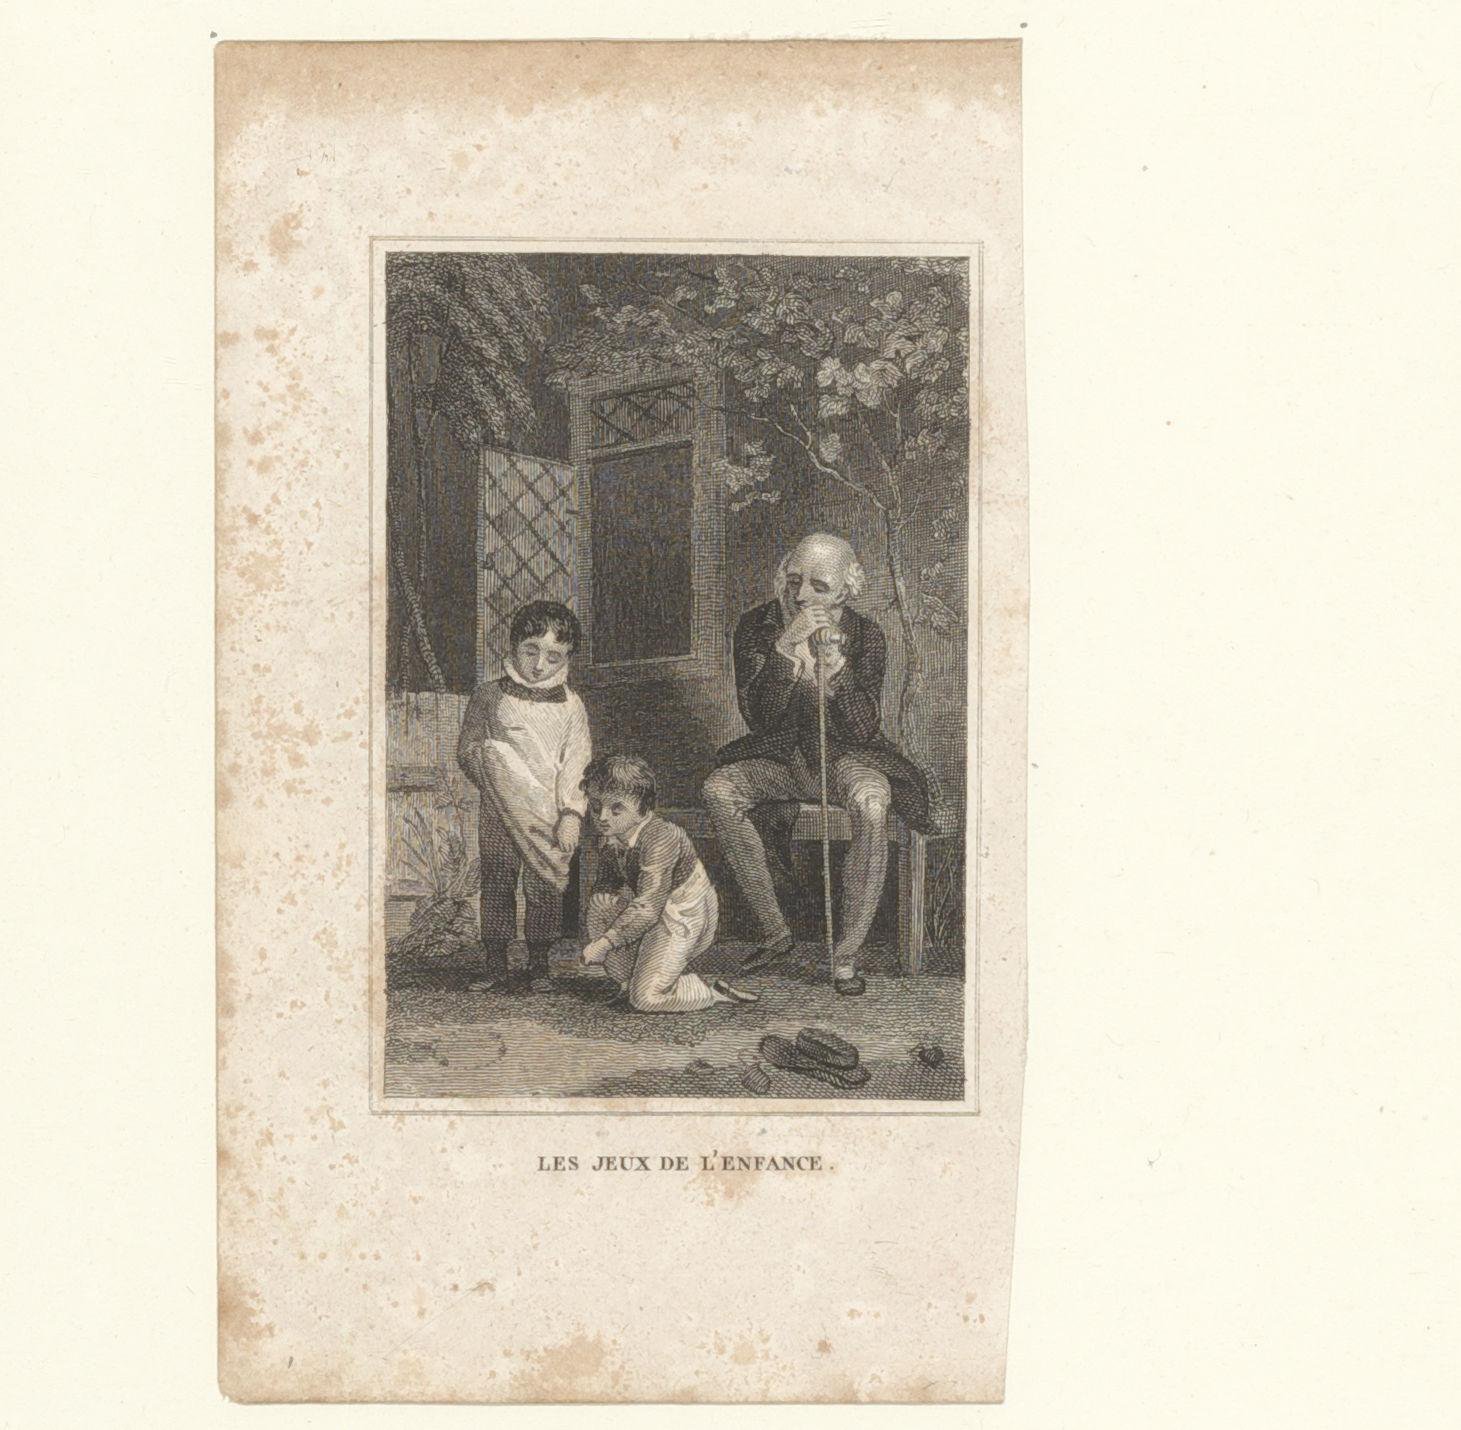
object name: print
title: Les jeux de l'enfance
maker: Anonymous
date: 1800-1899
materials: paper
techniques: etching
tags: children's games and plays, boy (child between toddler and youth), adult man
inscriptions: stamp, collector's mark: Lugt 1641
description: Onderwerpsrubrieken binnen de Atlas Zeden en Gewoonten: Zeden en Gewoonten in Engeren Zin, Des menschen beging, midden en einde, Kinderleven – Kinderspel en Kinderprenten.